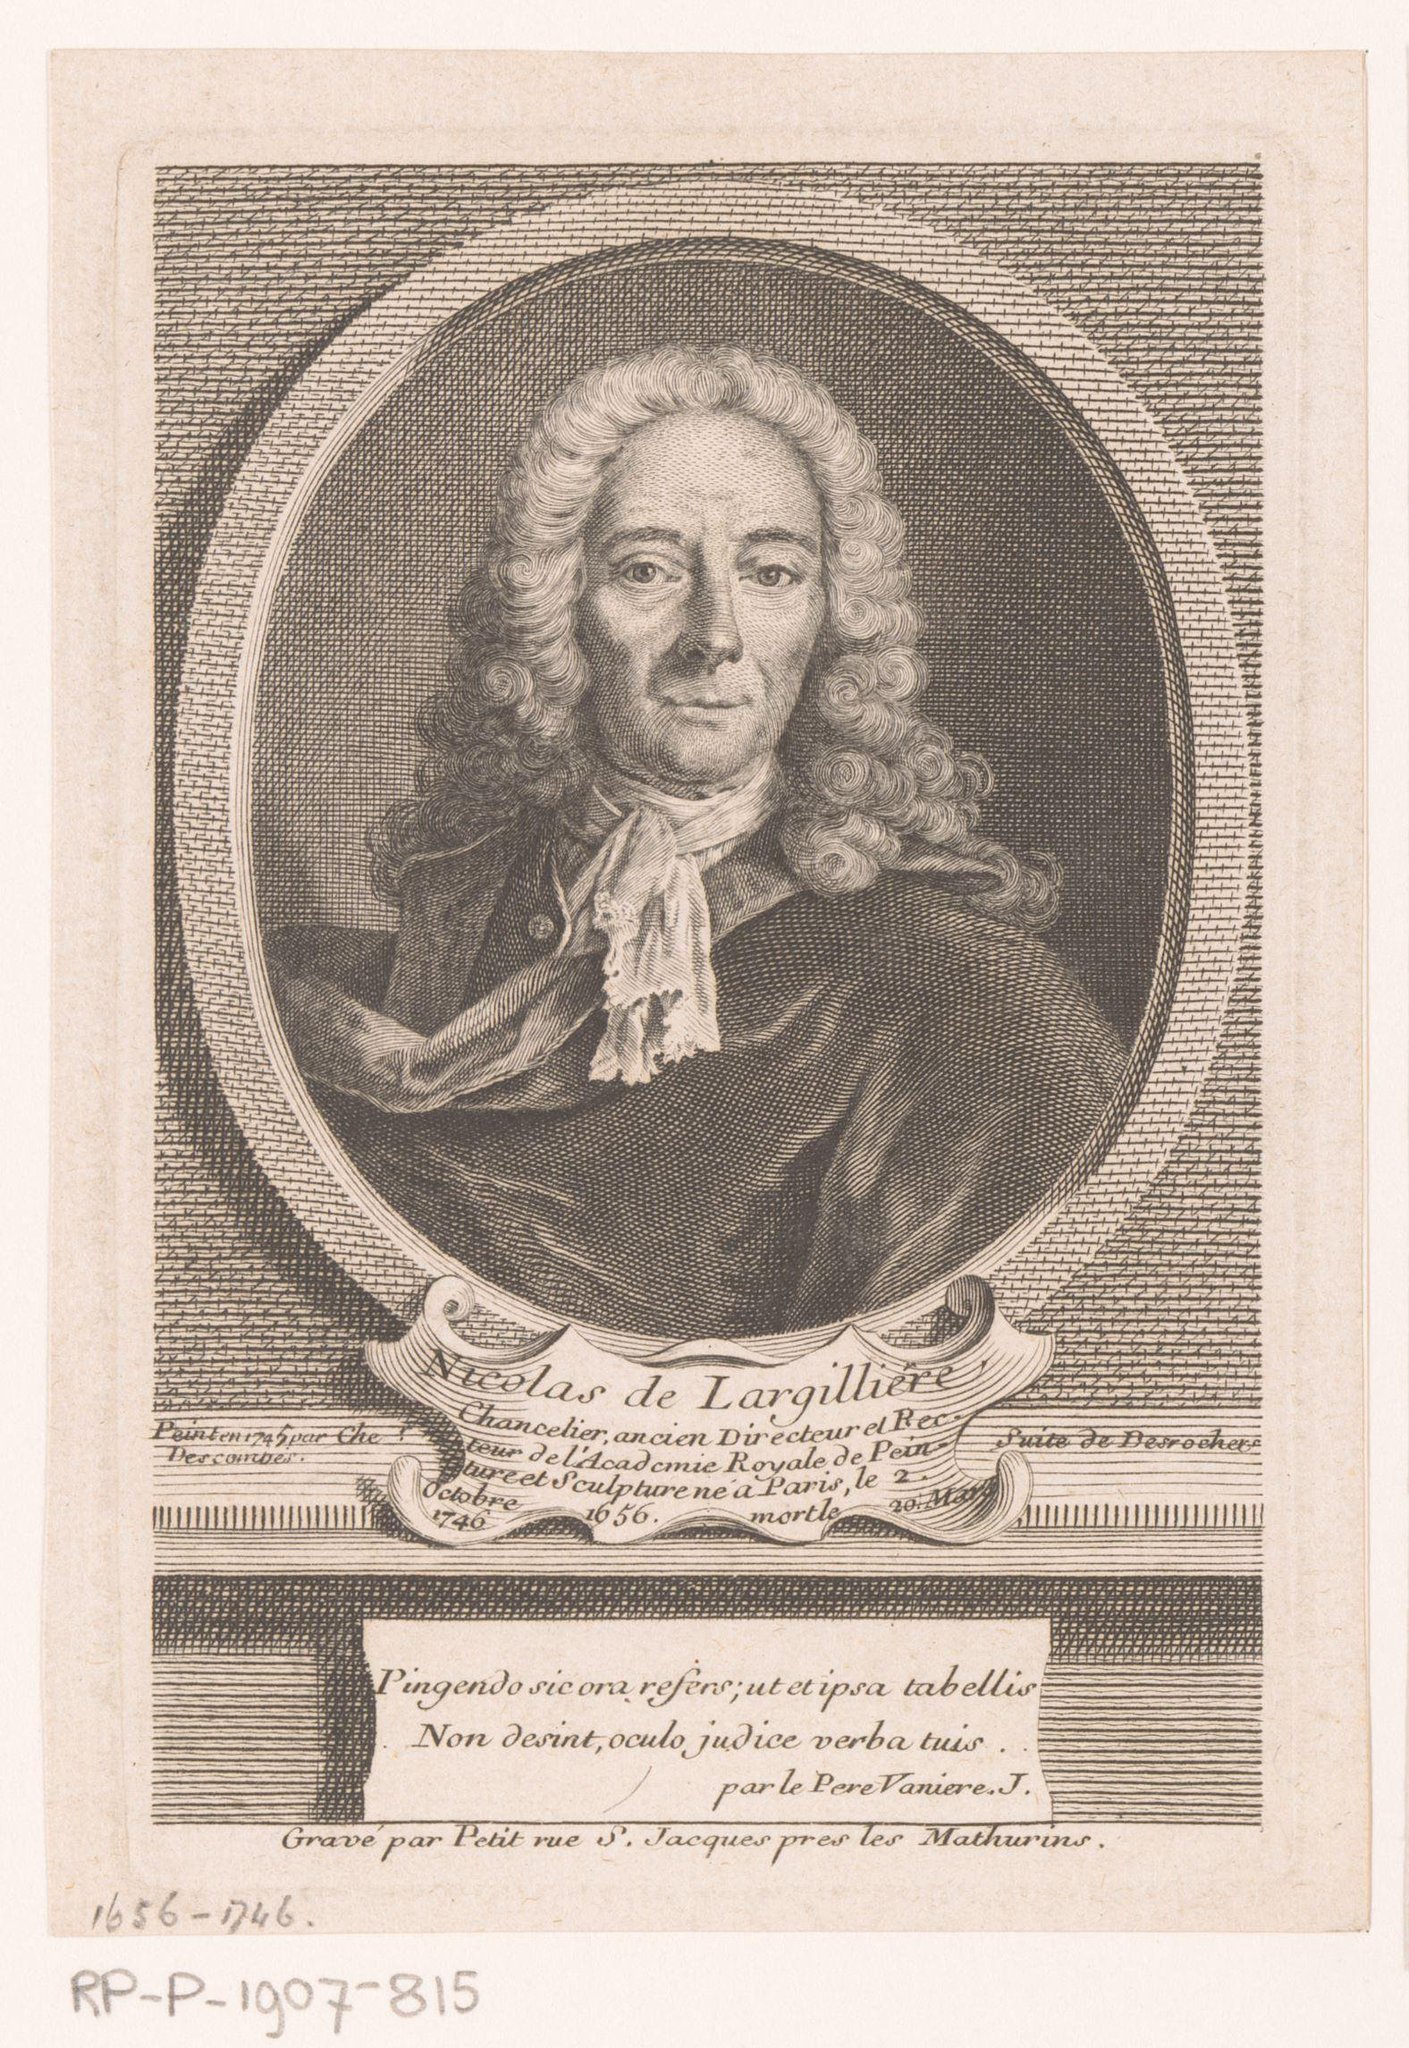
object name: print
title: Portret van Nicolas de Largilliere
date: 1746-1760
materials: paper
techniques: engraving, etching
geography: paris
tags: paris, painter, draughtsman, nicolas de largillière, historical persons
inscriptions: collector's mark: Lugt 2228